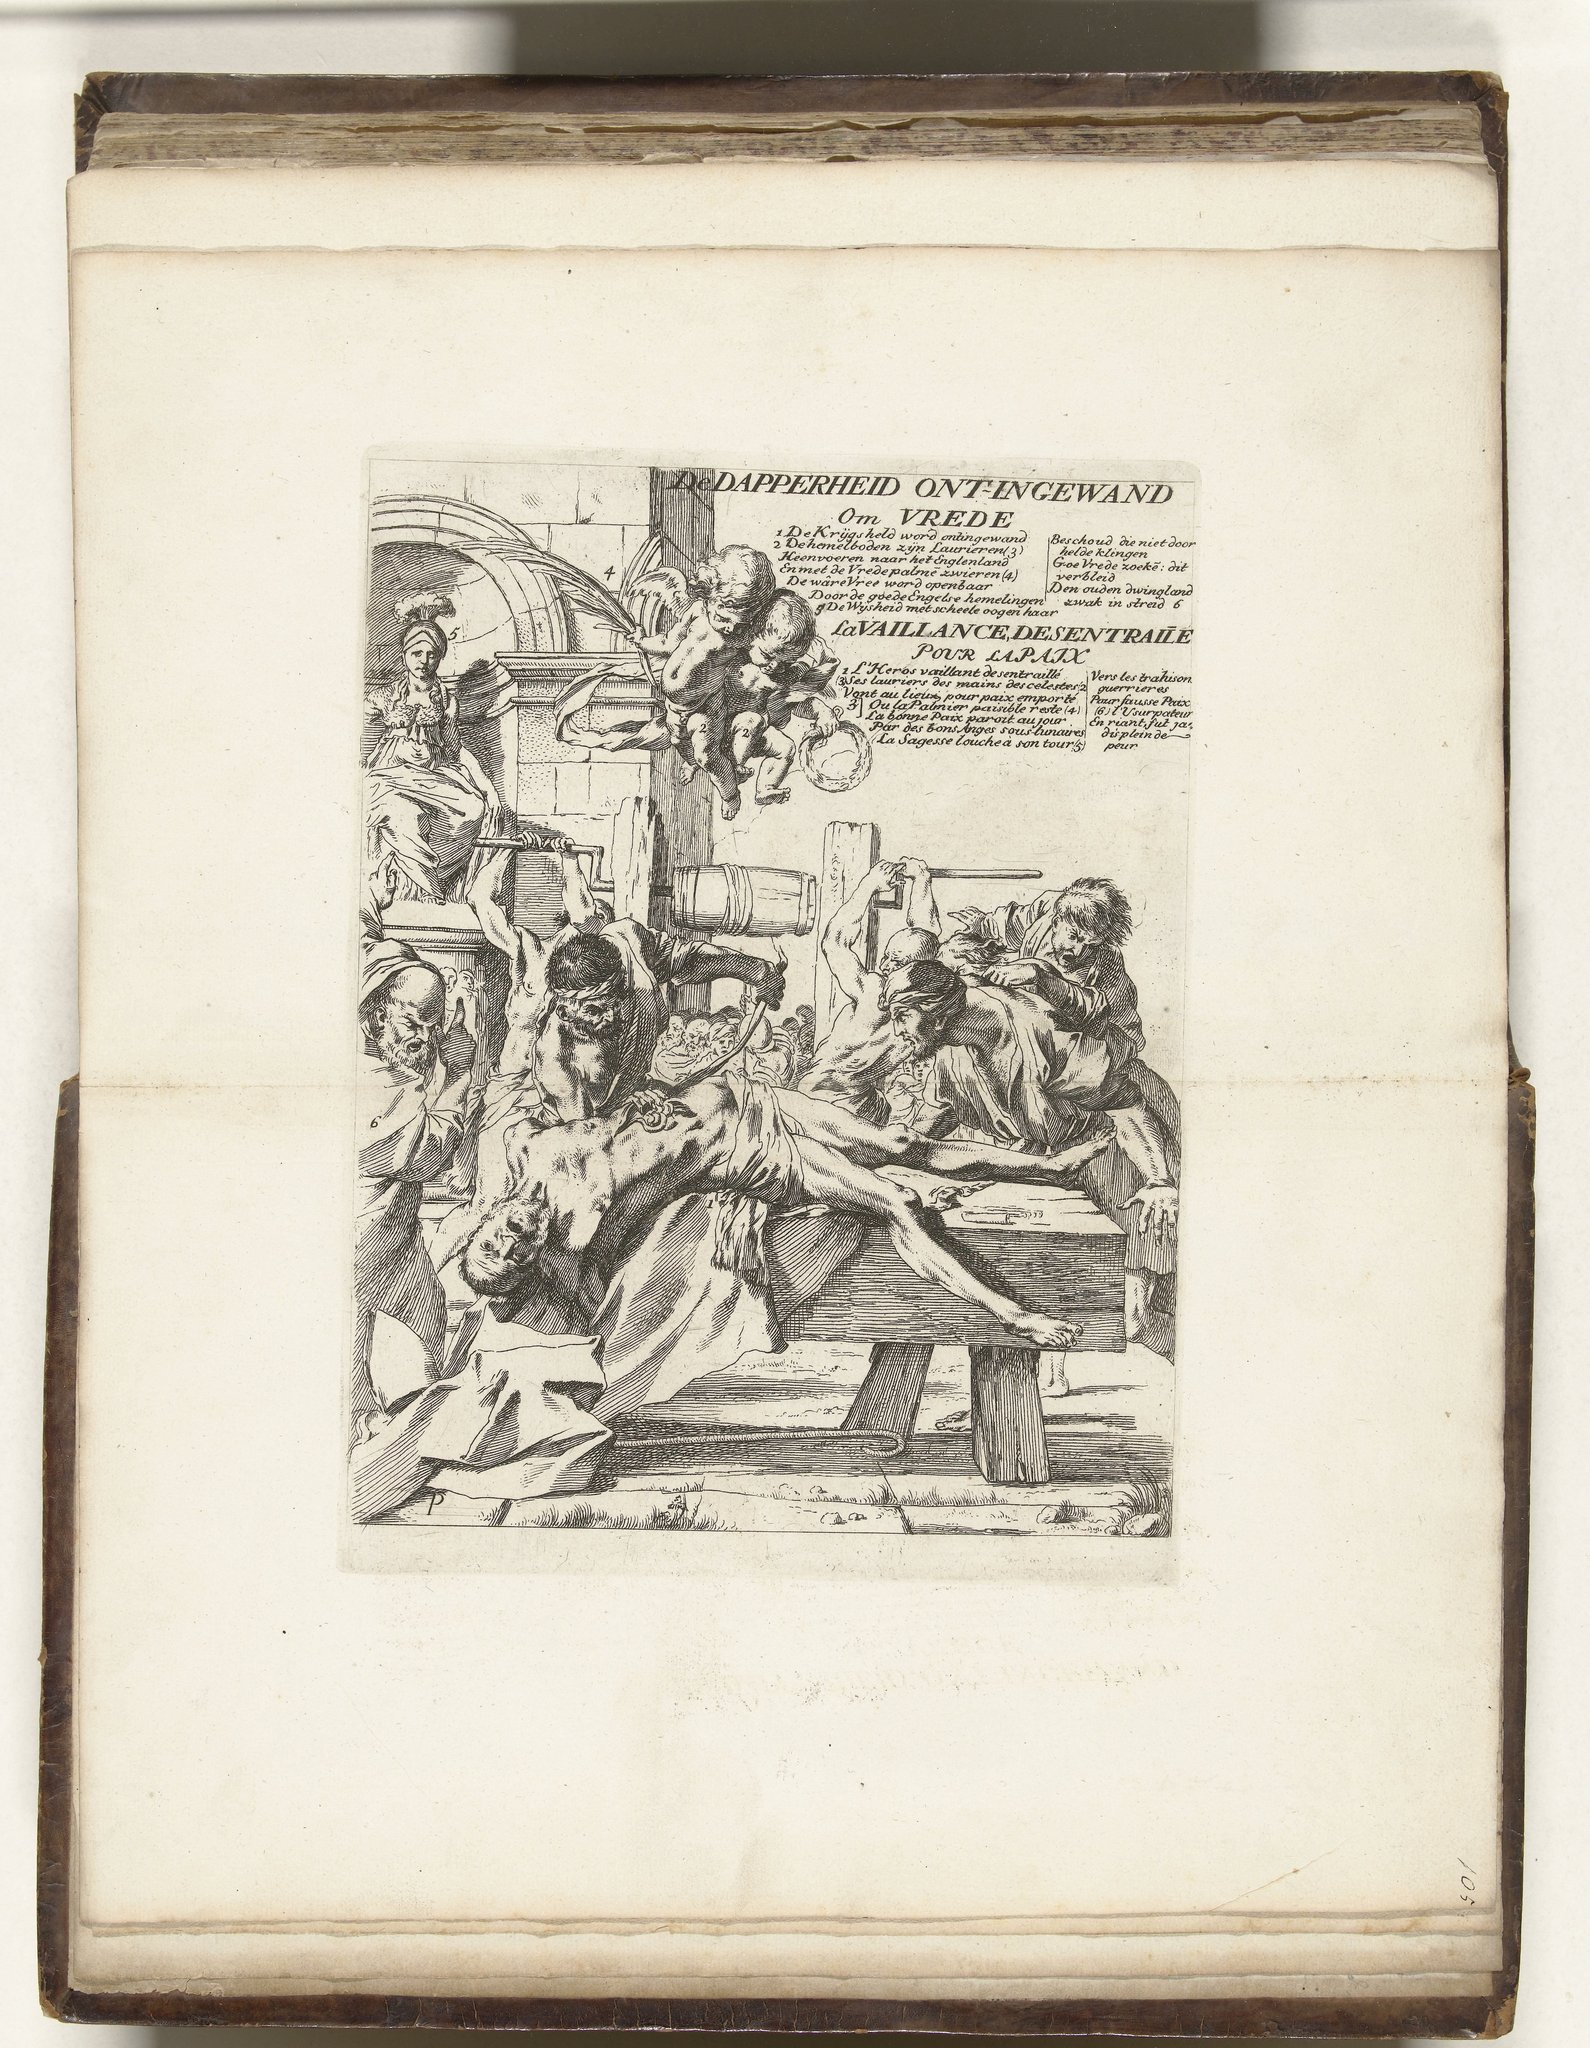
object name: print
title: Platen over de Vrede van Utrecht van 1713 / 't Lusthof van Momus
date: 1630-1650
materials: paper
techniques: etching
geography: italy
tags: st. erasmus lies naked on a block; his bowels are wound on to a windlass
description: Martelaarschap van de heilige Erasmus. De voorstelling hier gebruikt in verband met de Vrede van Utrecht, 1713. In de plaat verzen in het Nederlands en Frans. Onderdeel van een groep van 28 nieuwe en oude platen aangepast ter illustratie van de Vrede van Utrecht in 1713. Onderdeel van het prentwerk uitgegeven onder de verzameltitel 't Lust-Hof van Momus met de gebundelde series van spotprenten tijdens de jaren 1701-1713 van de Spaanse Successieoorlog.